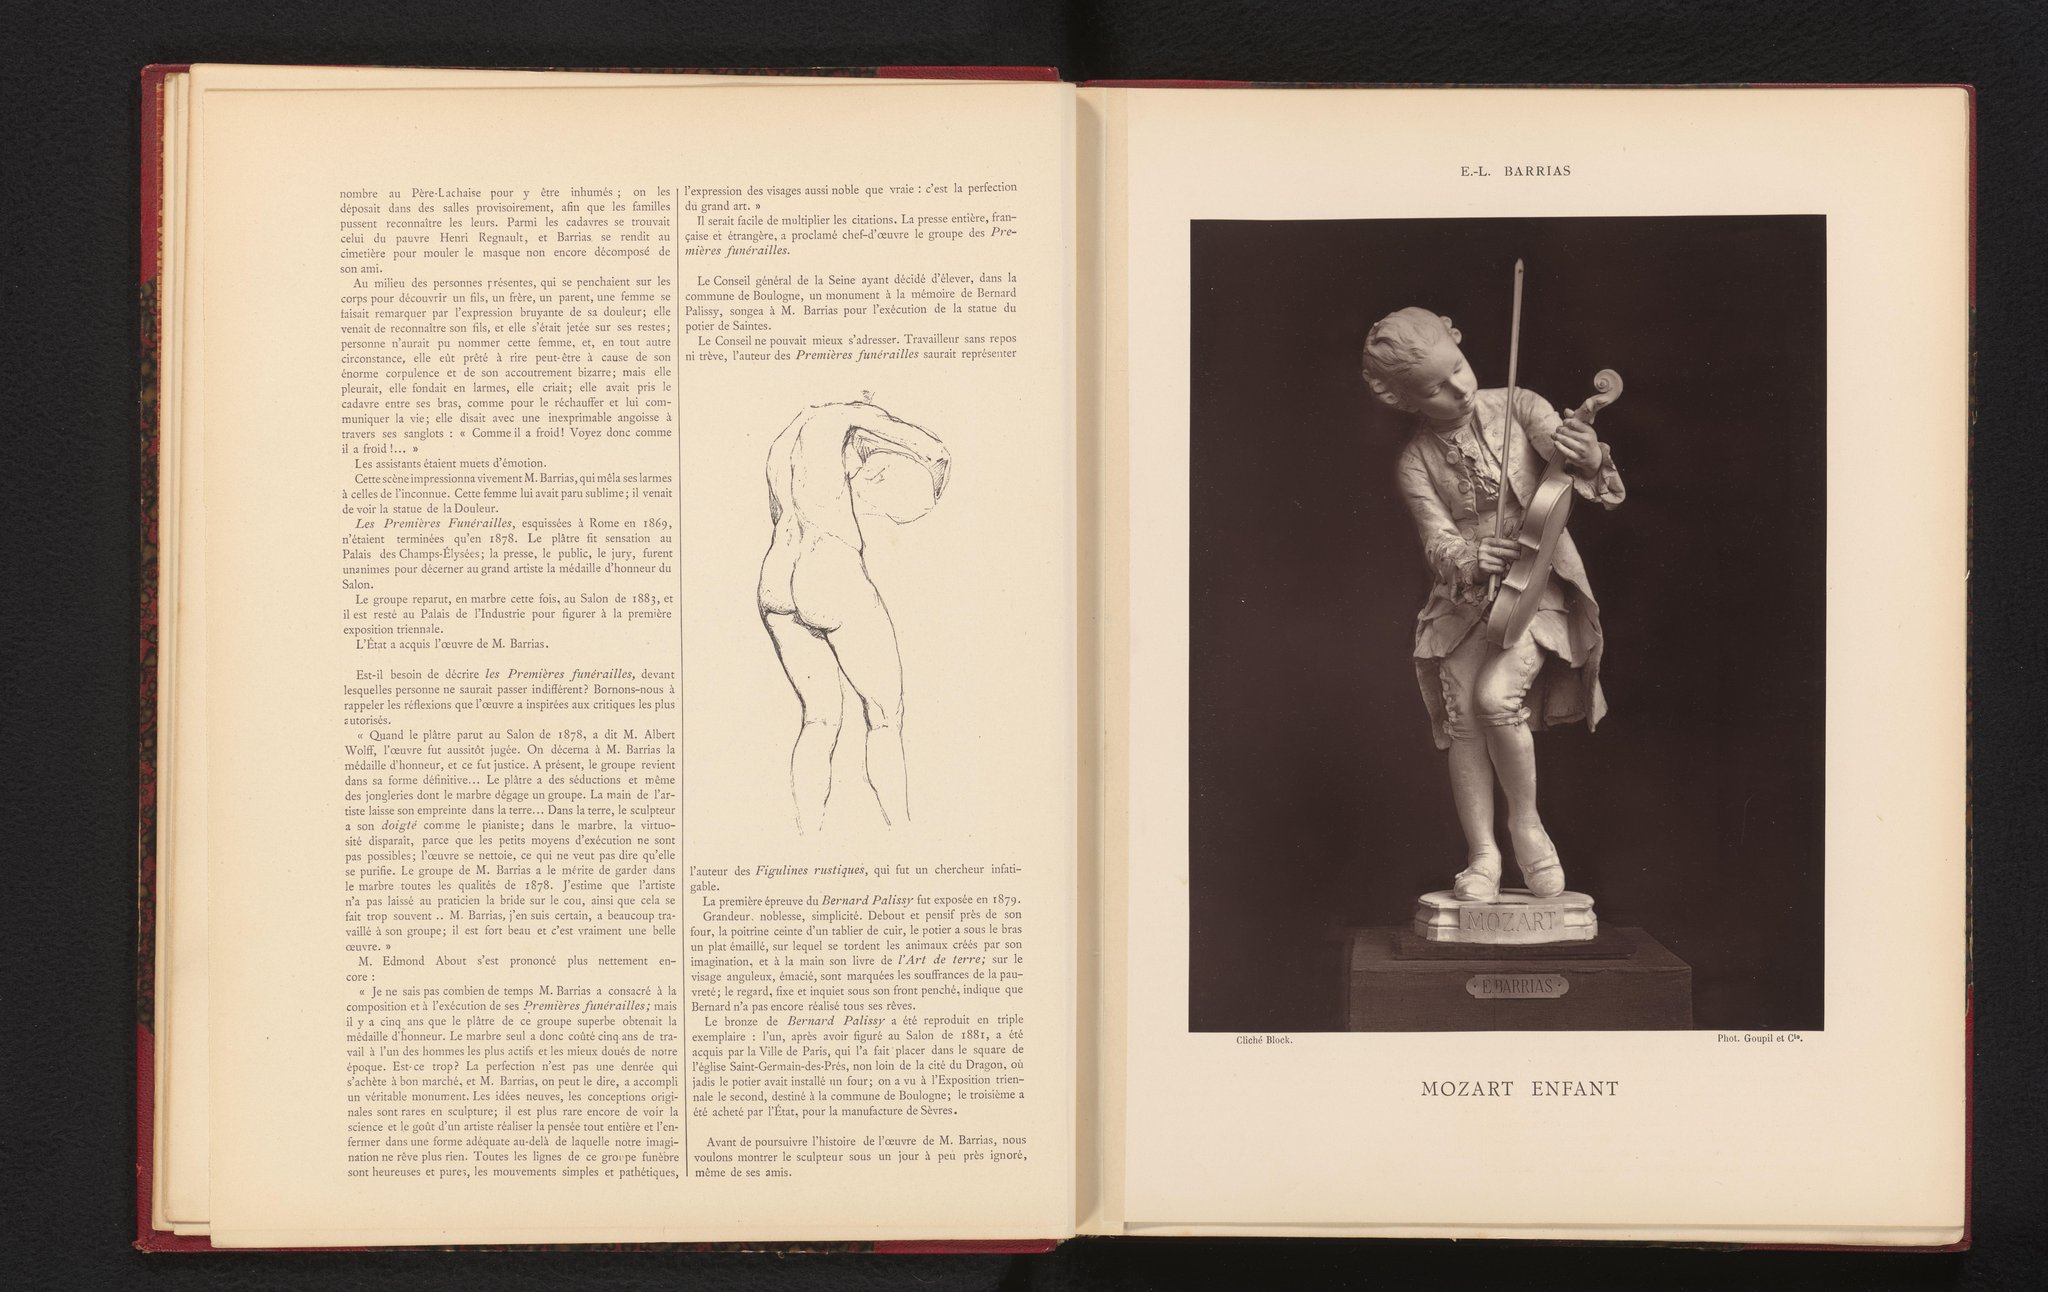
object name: page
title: Mozart enfant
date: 1879-1884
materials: paper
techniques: woodburytype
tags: vienna, children playing musical instruments